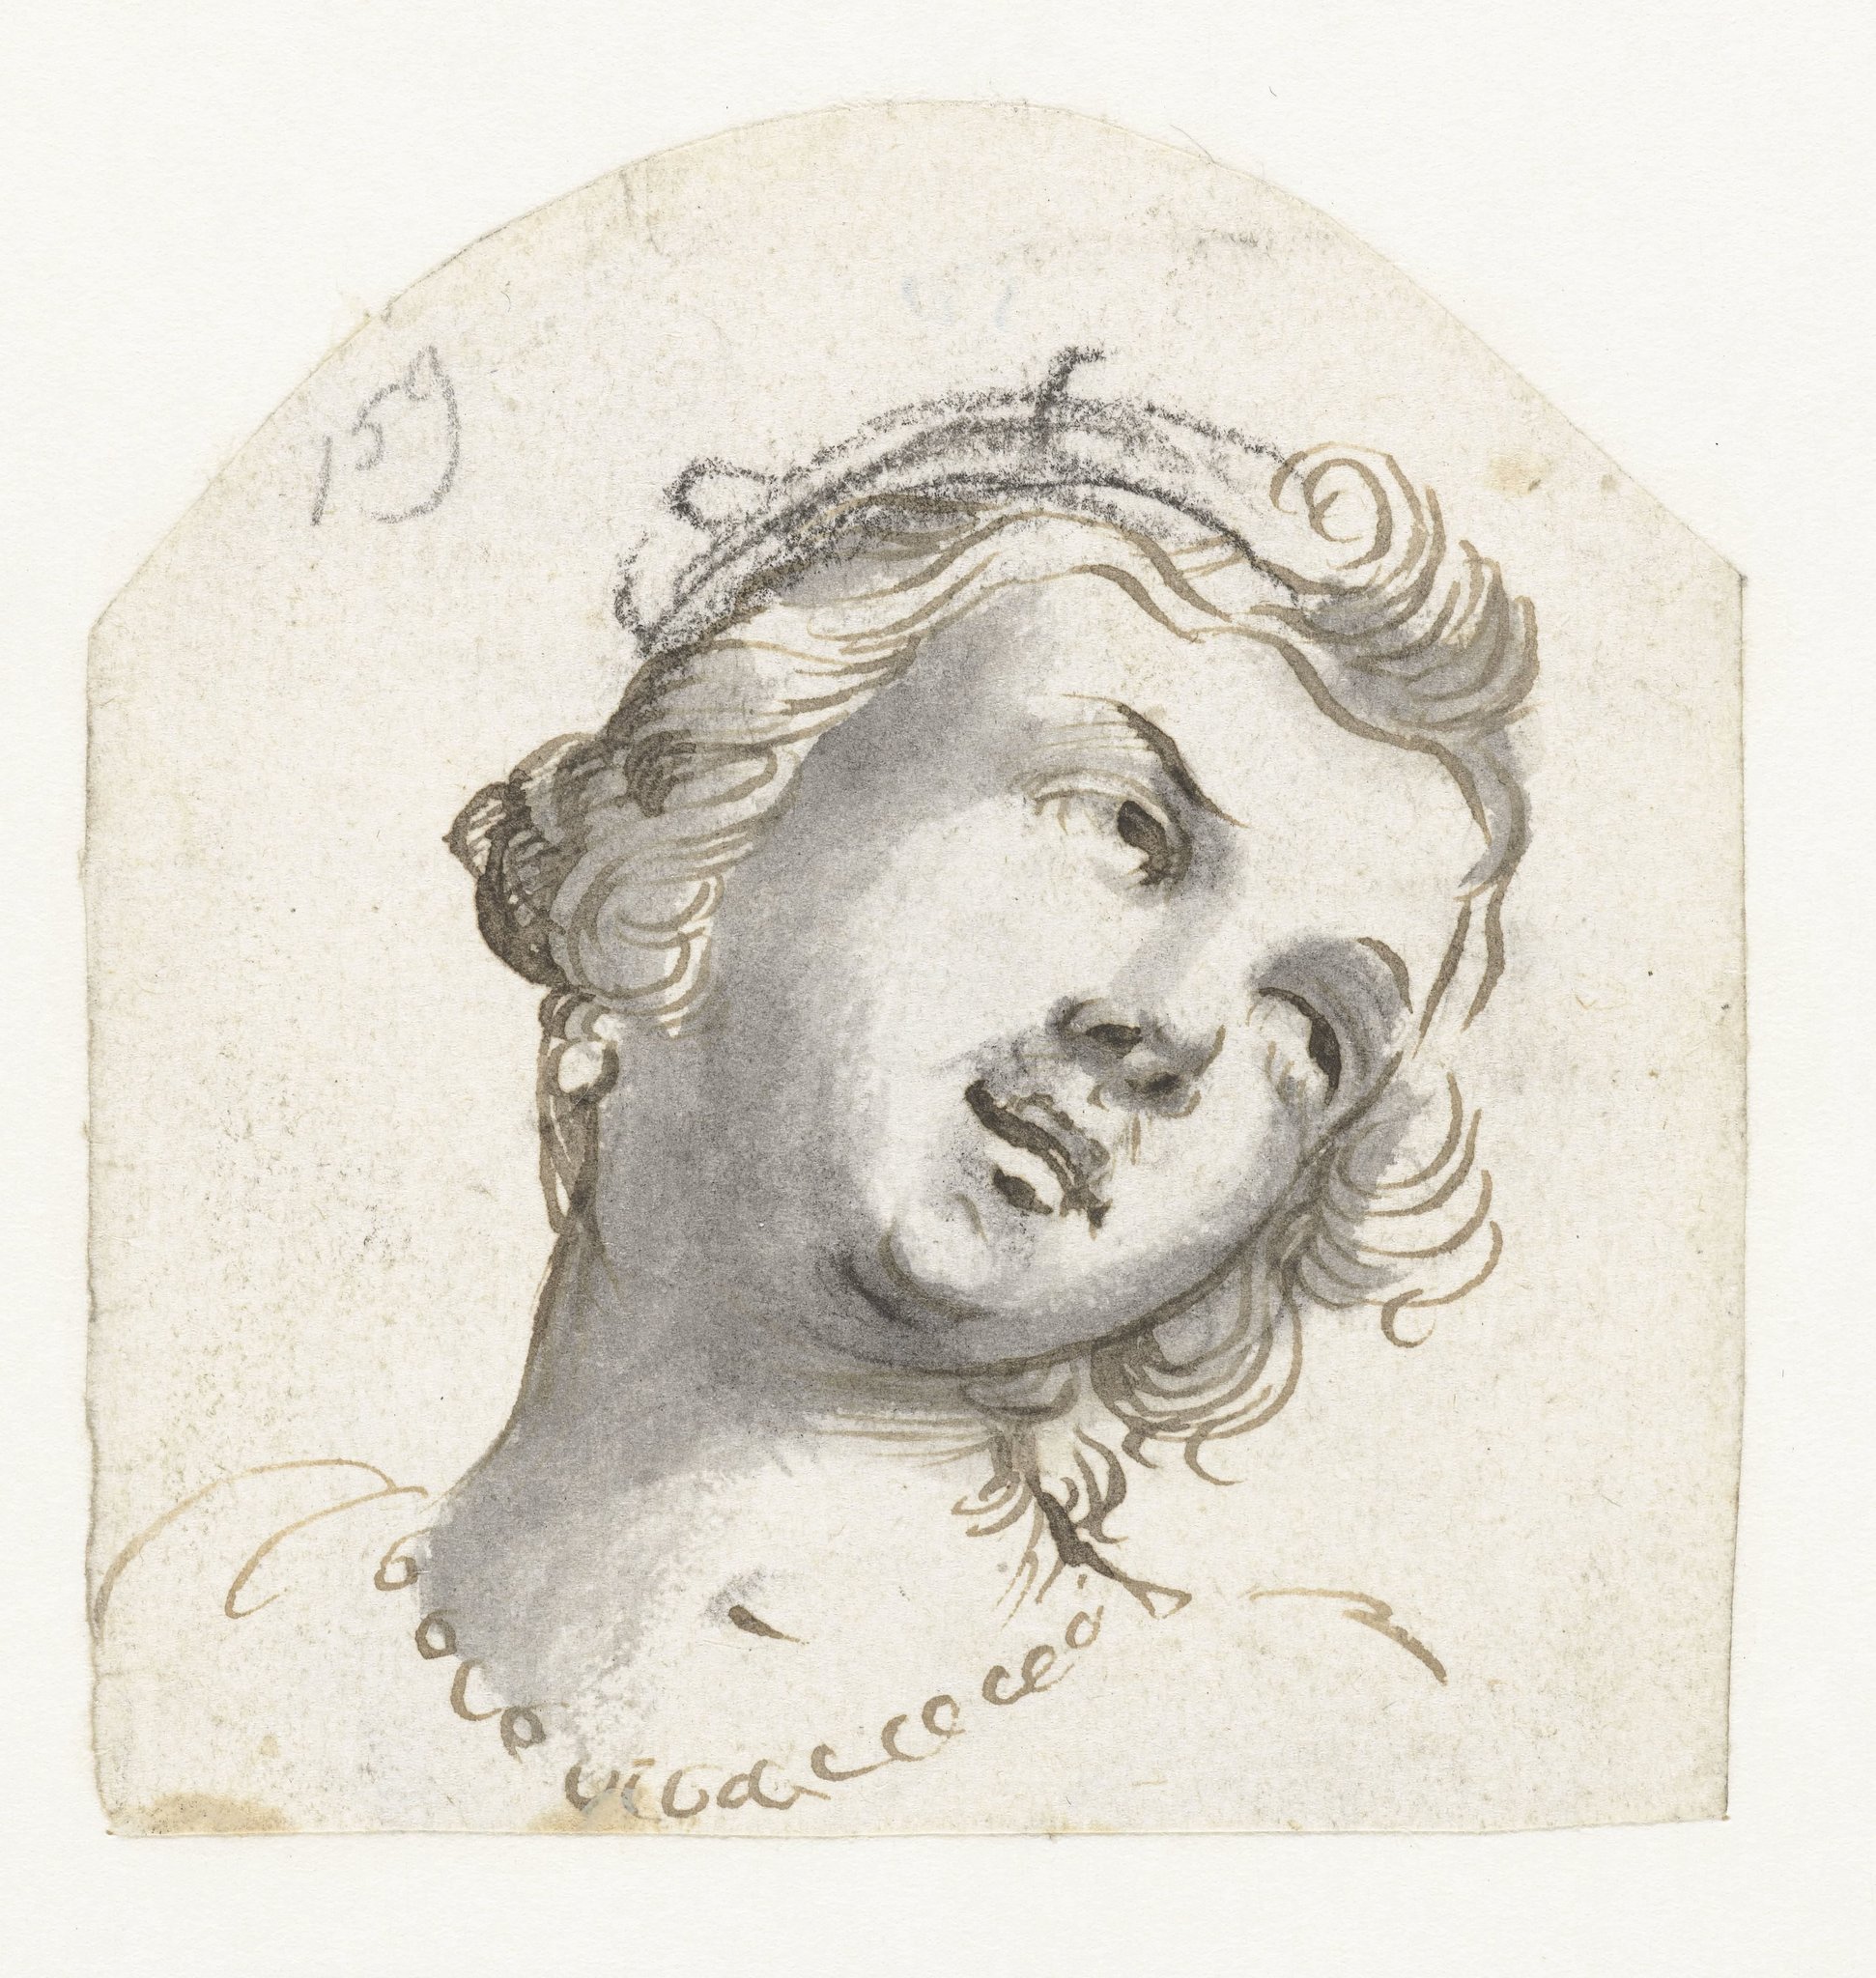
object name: drawing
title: Hoofd van Venus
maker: moses ter borch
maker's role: draughtsman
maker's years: 1645-1667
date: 1659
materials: chalk, ink, paper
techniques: brush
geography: netherlands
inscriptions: inscription: ‘Ger Sr / G Ter Borch Sr.’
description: Kopie van het hoofd van Venus in J. Saenredam's Sine Bacchus et Ceres friget Venus (naar A. Bloemaert). Hoort bij serie tekeningen met kopieën naar prenten uit dezelfde periode (cat.nrs. M 46-51).